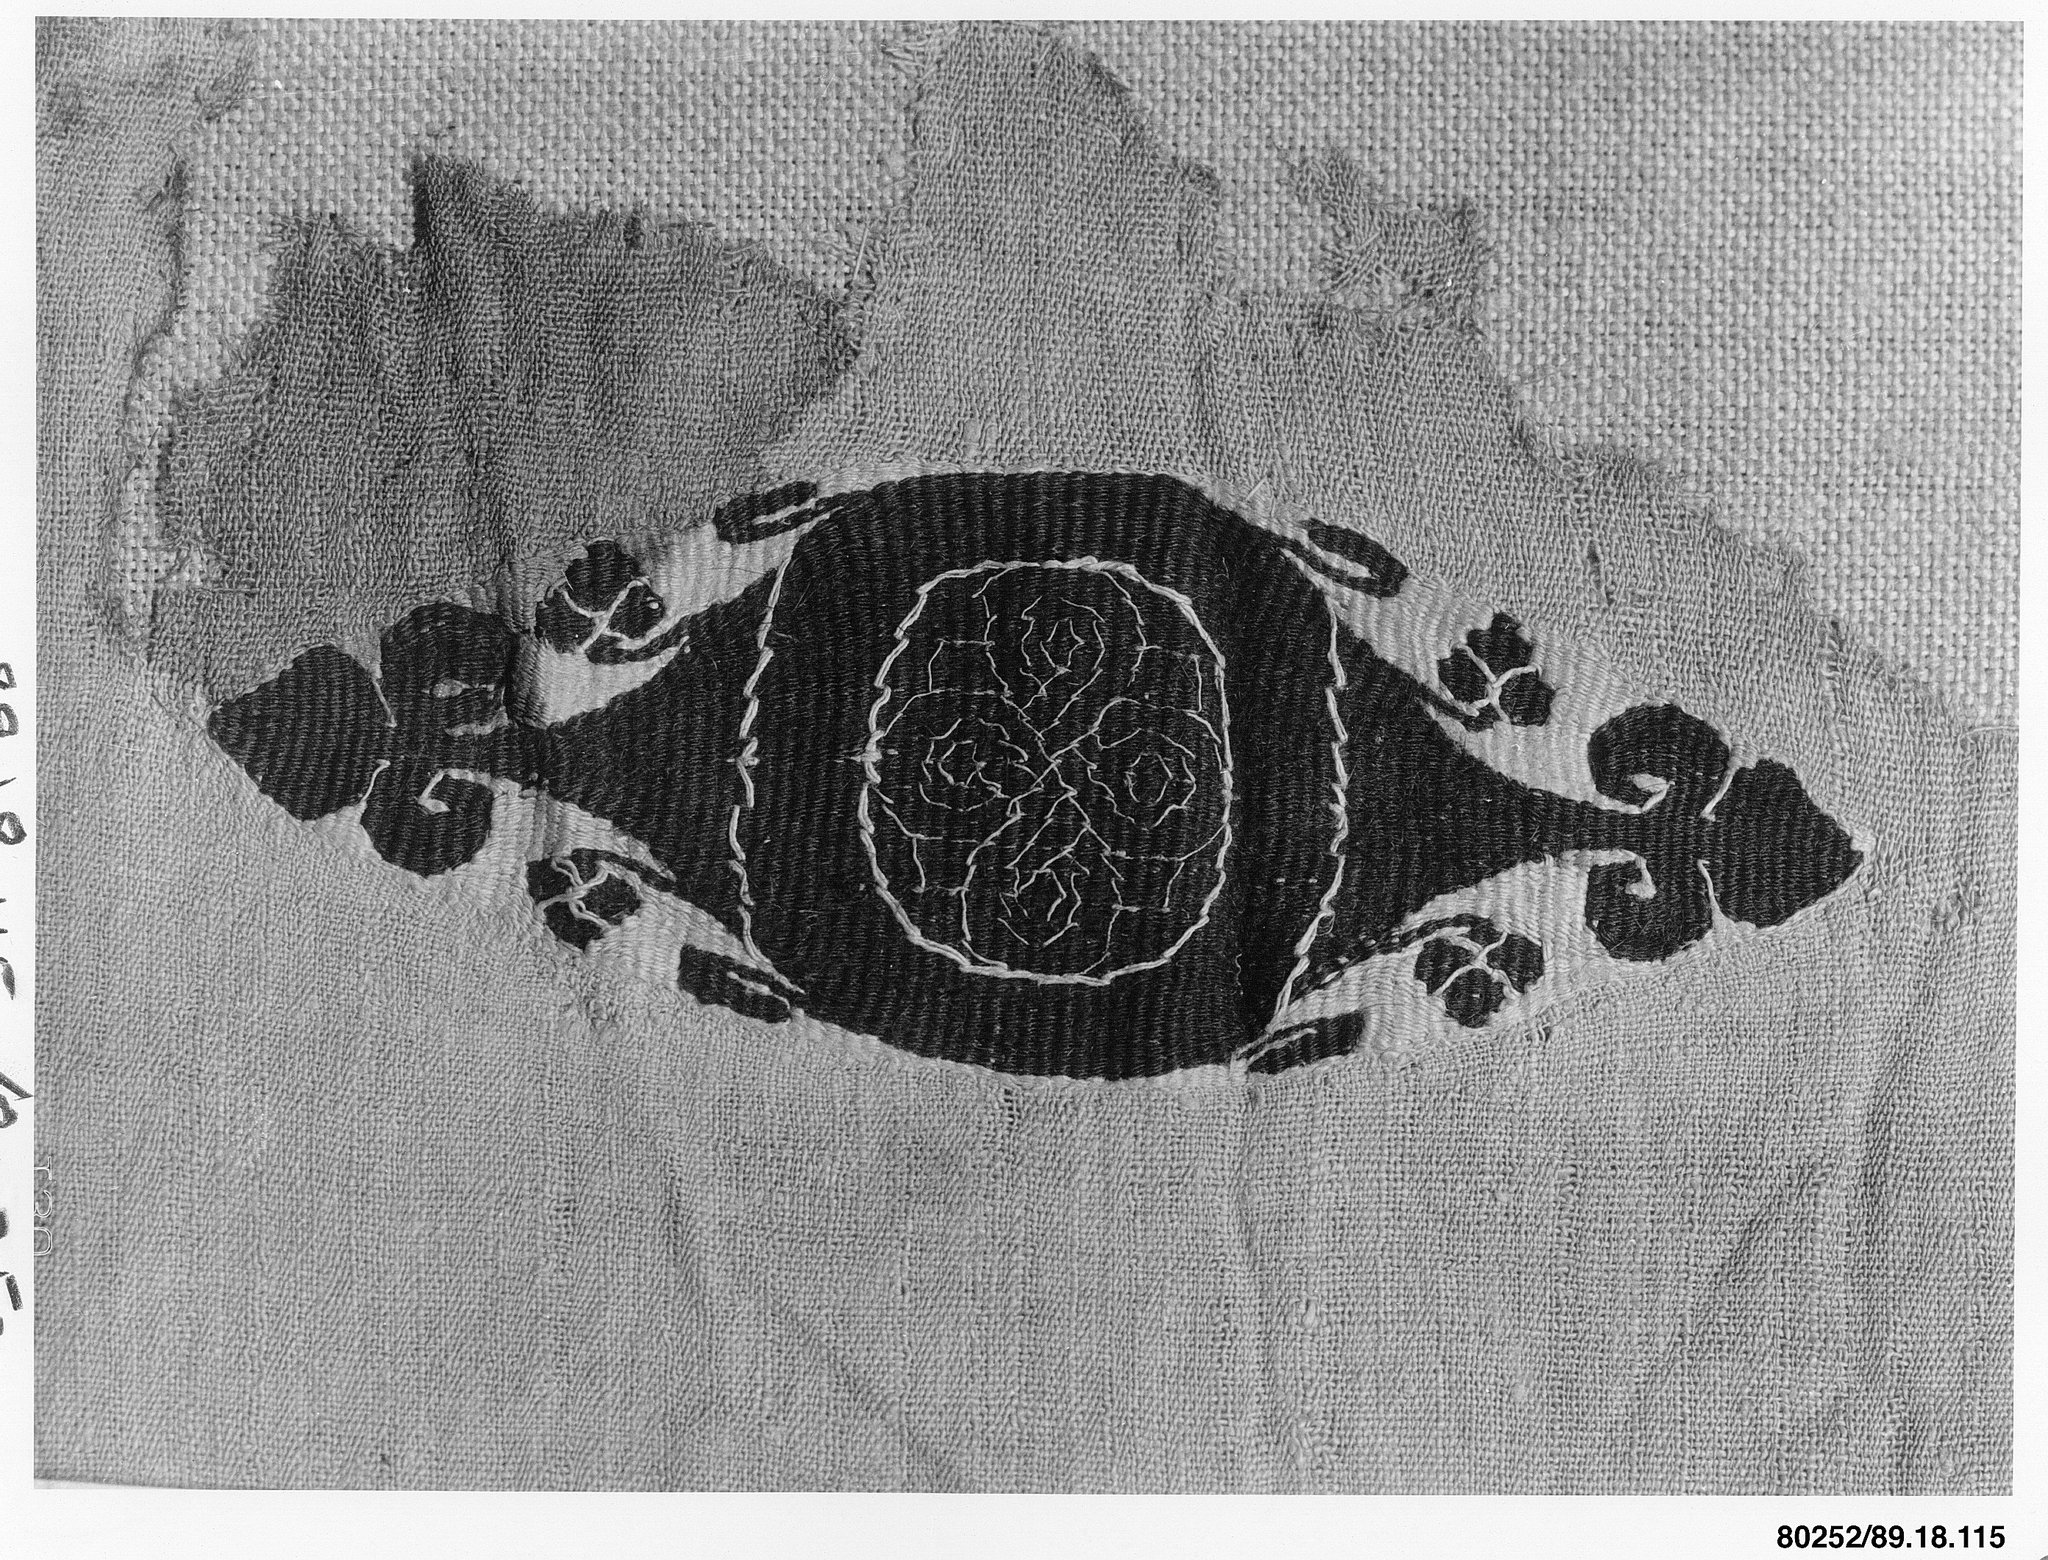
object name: textile fragment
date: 301-400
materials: linen, wool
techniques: weave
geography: egypt